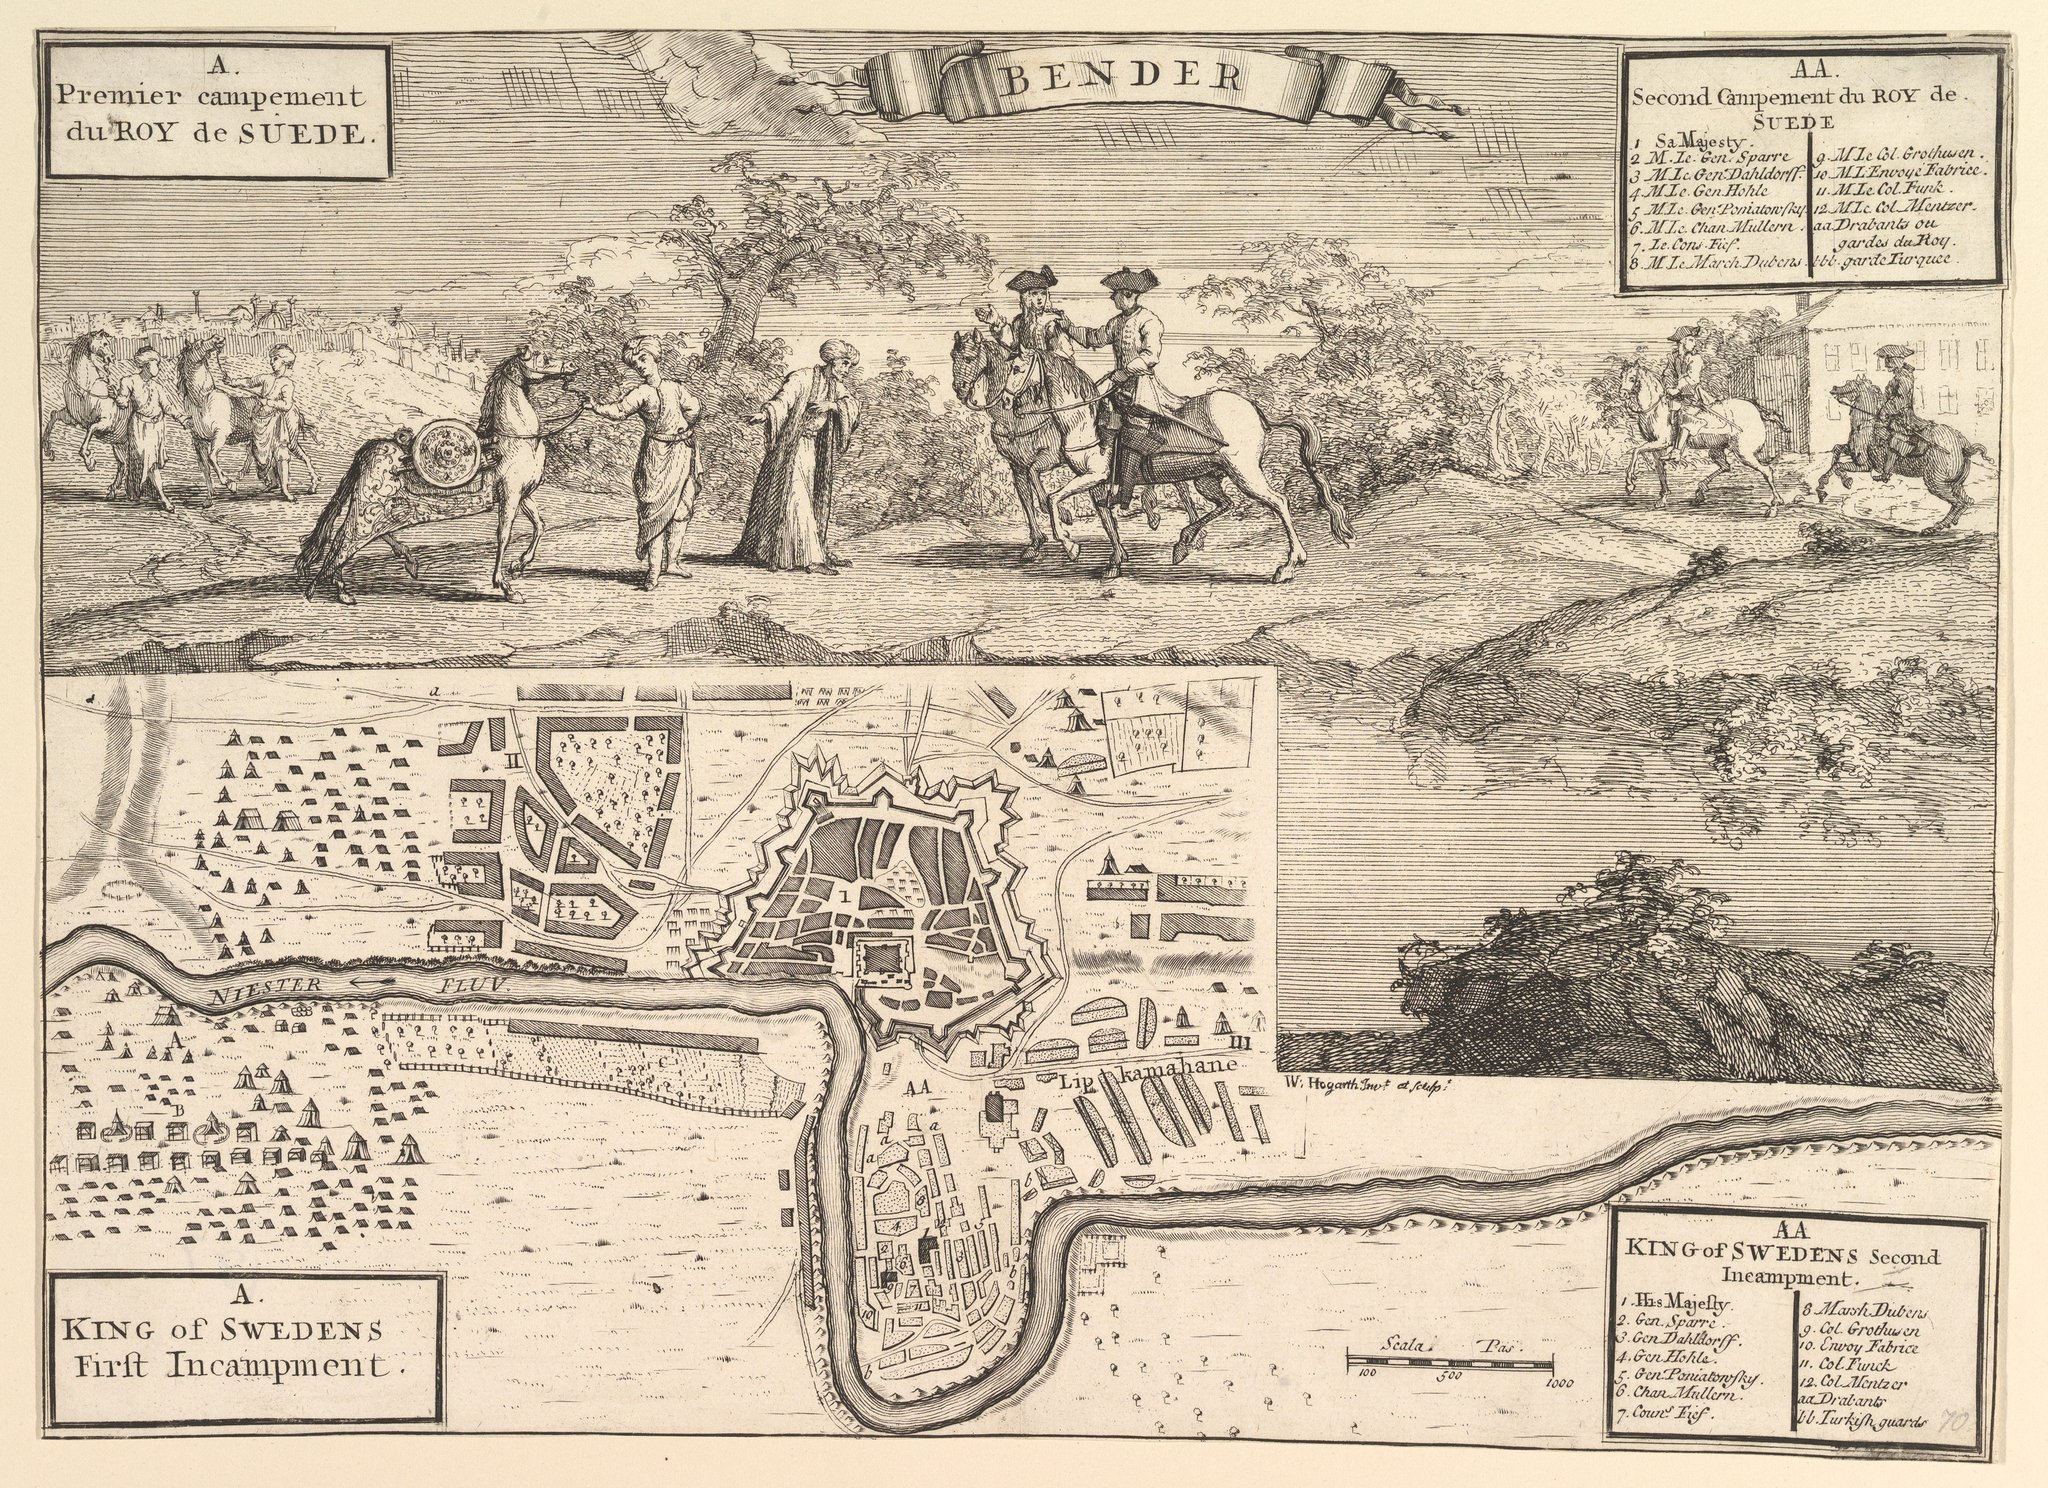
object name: print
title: Charles XII at Bender (Aubry de La Mottraye's "Travels throughout Europe, Asia and into Part of Africa...," London, 1724, vol. II, pl. 30)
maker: william hogarth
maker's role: artist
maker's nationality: british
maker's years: 1697-1764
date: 1723-1724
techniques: engraving, etching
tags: men,horses